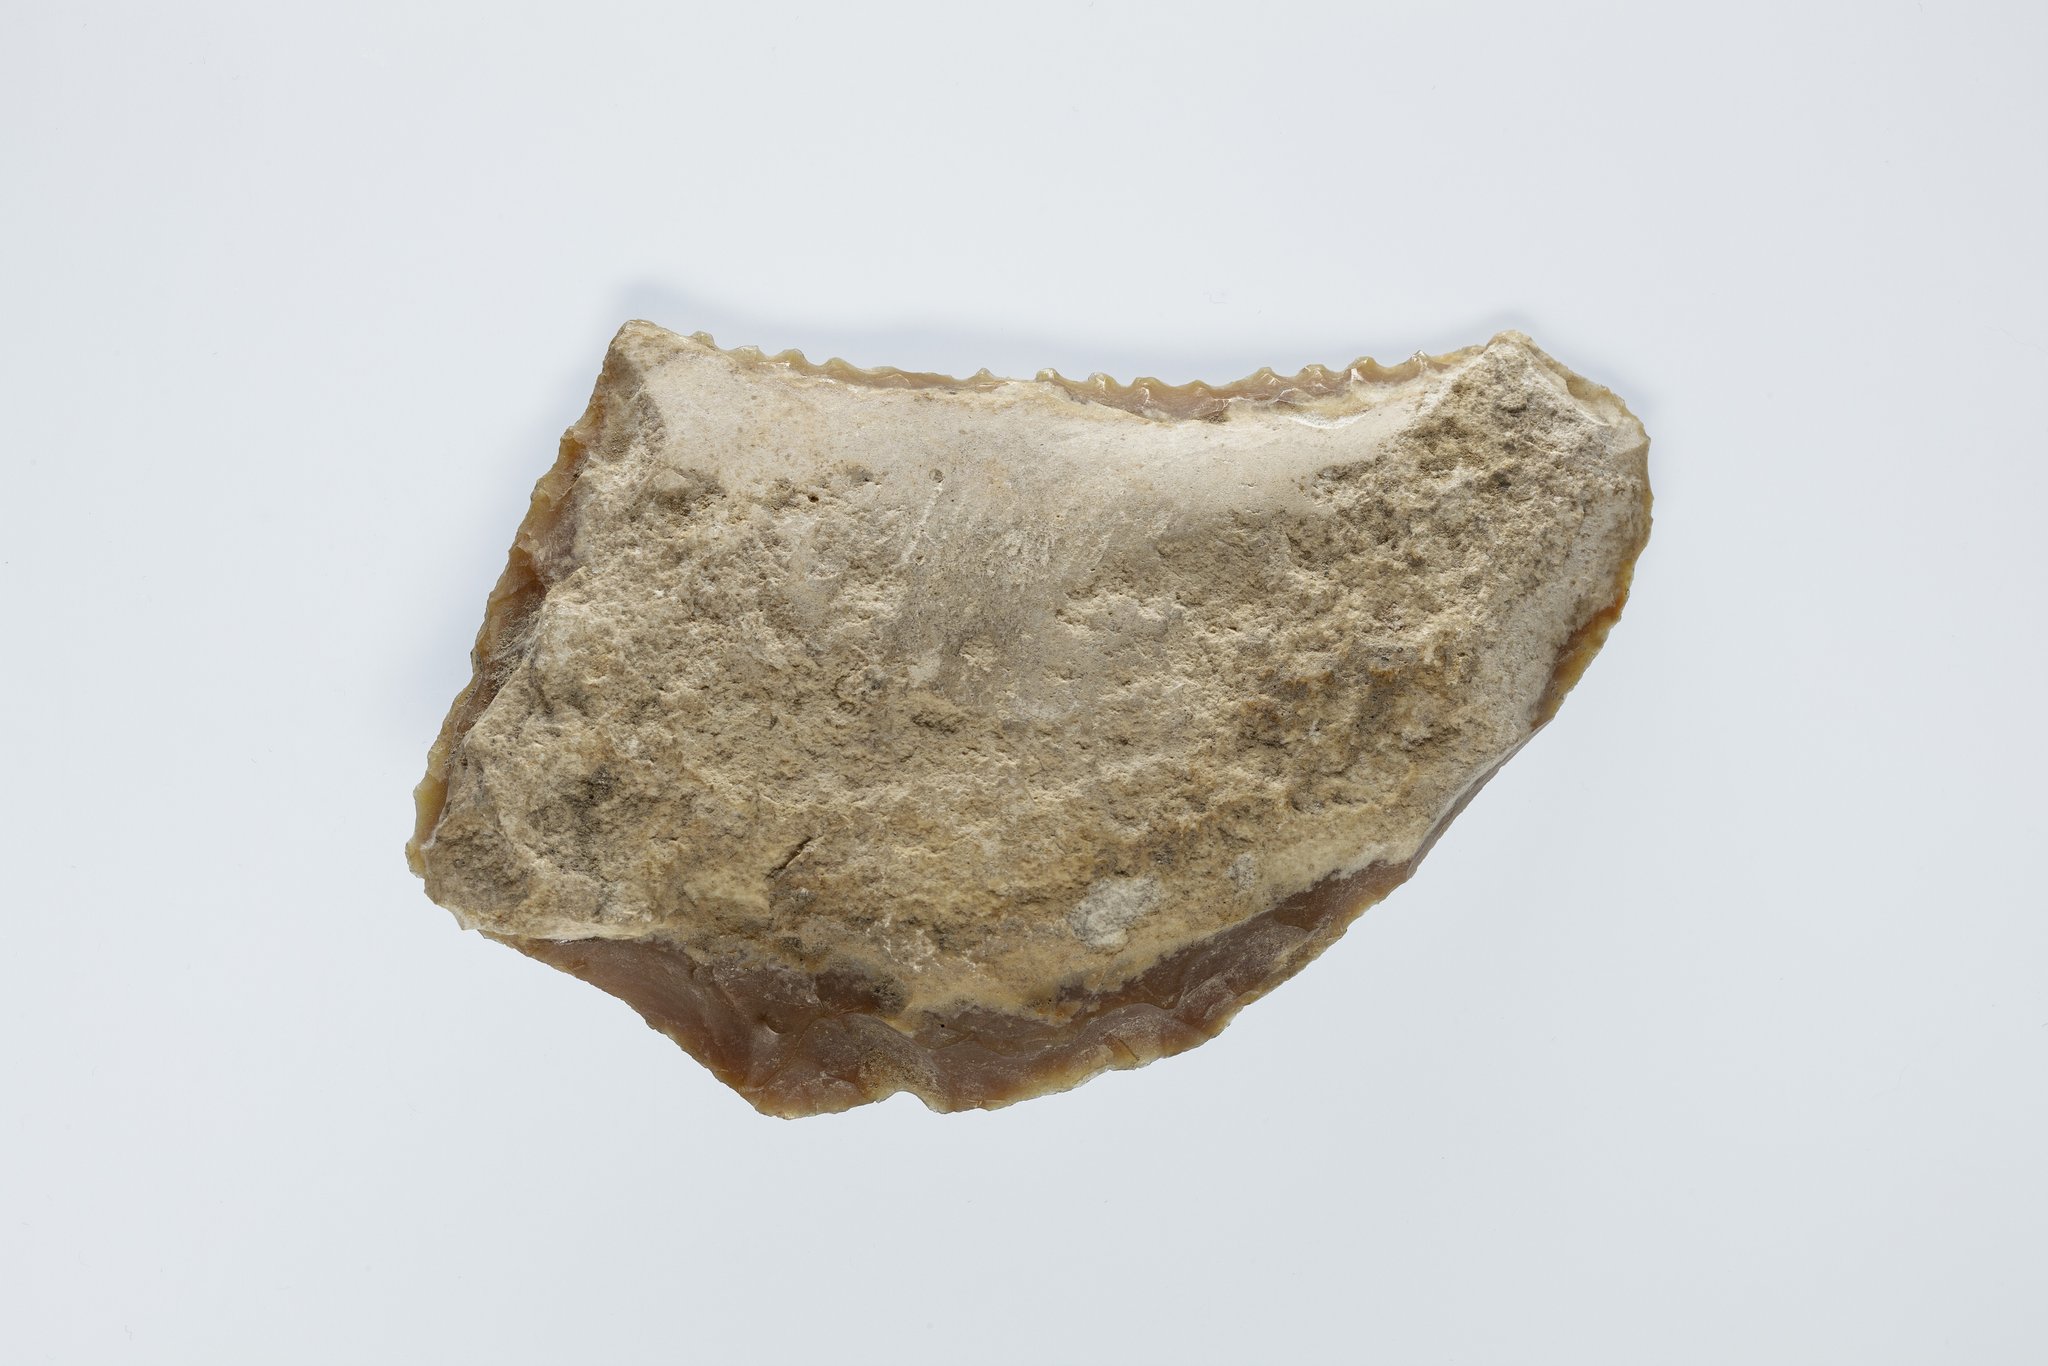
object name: sickle, denticulate, truncated, backed, geometric, tool, element, adhesive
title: Sickle Insert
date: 1186-1070 BCE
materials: stone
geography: egypt